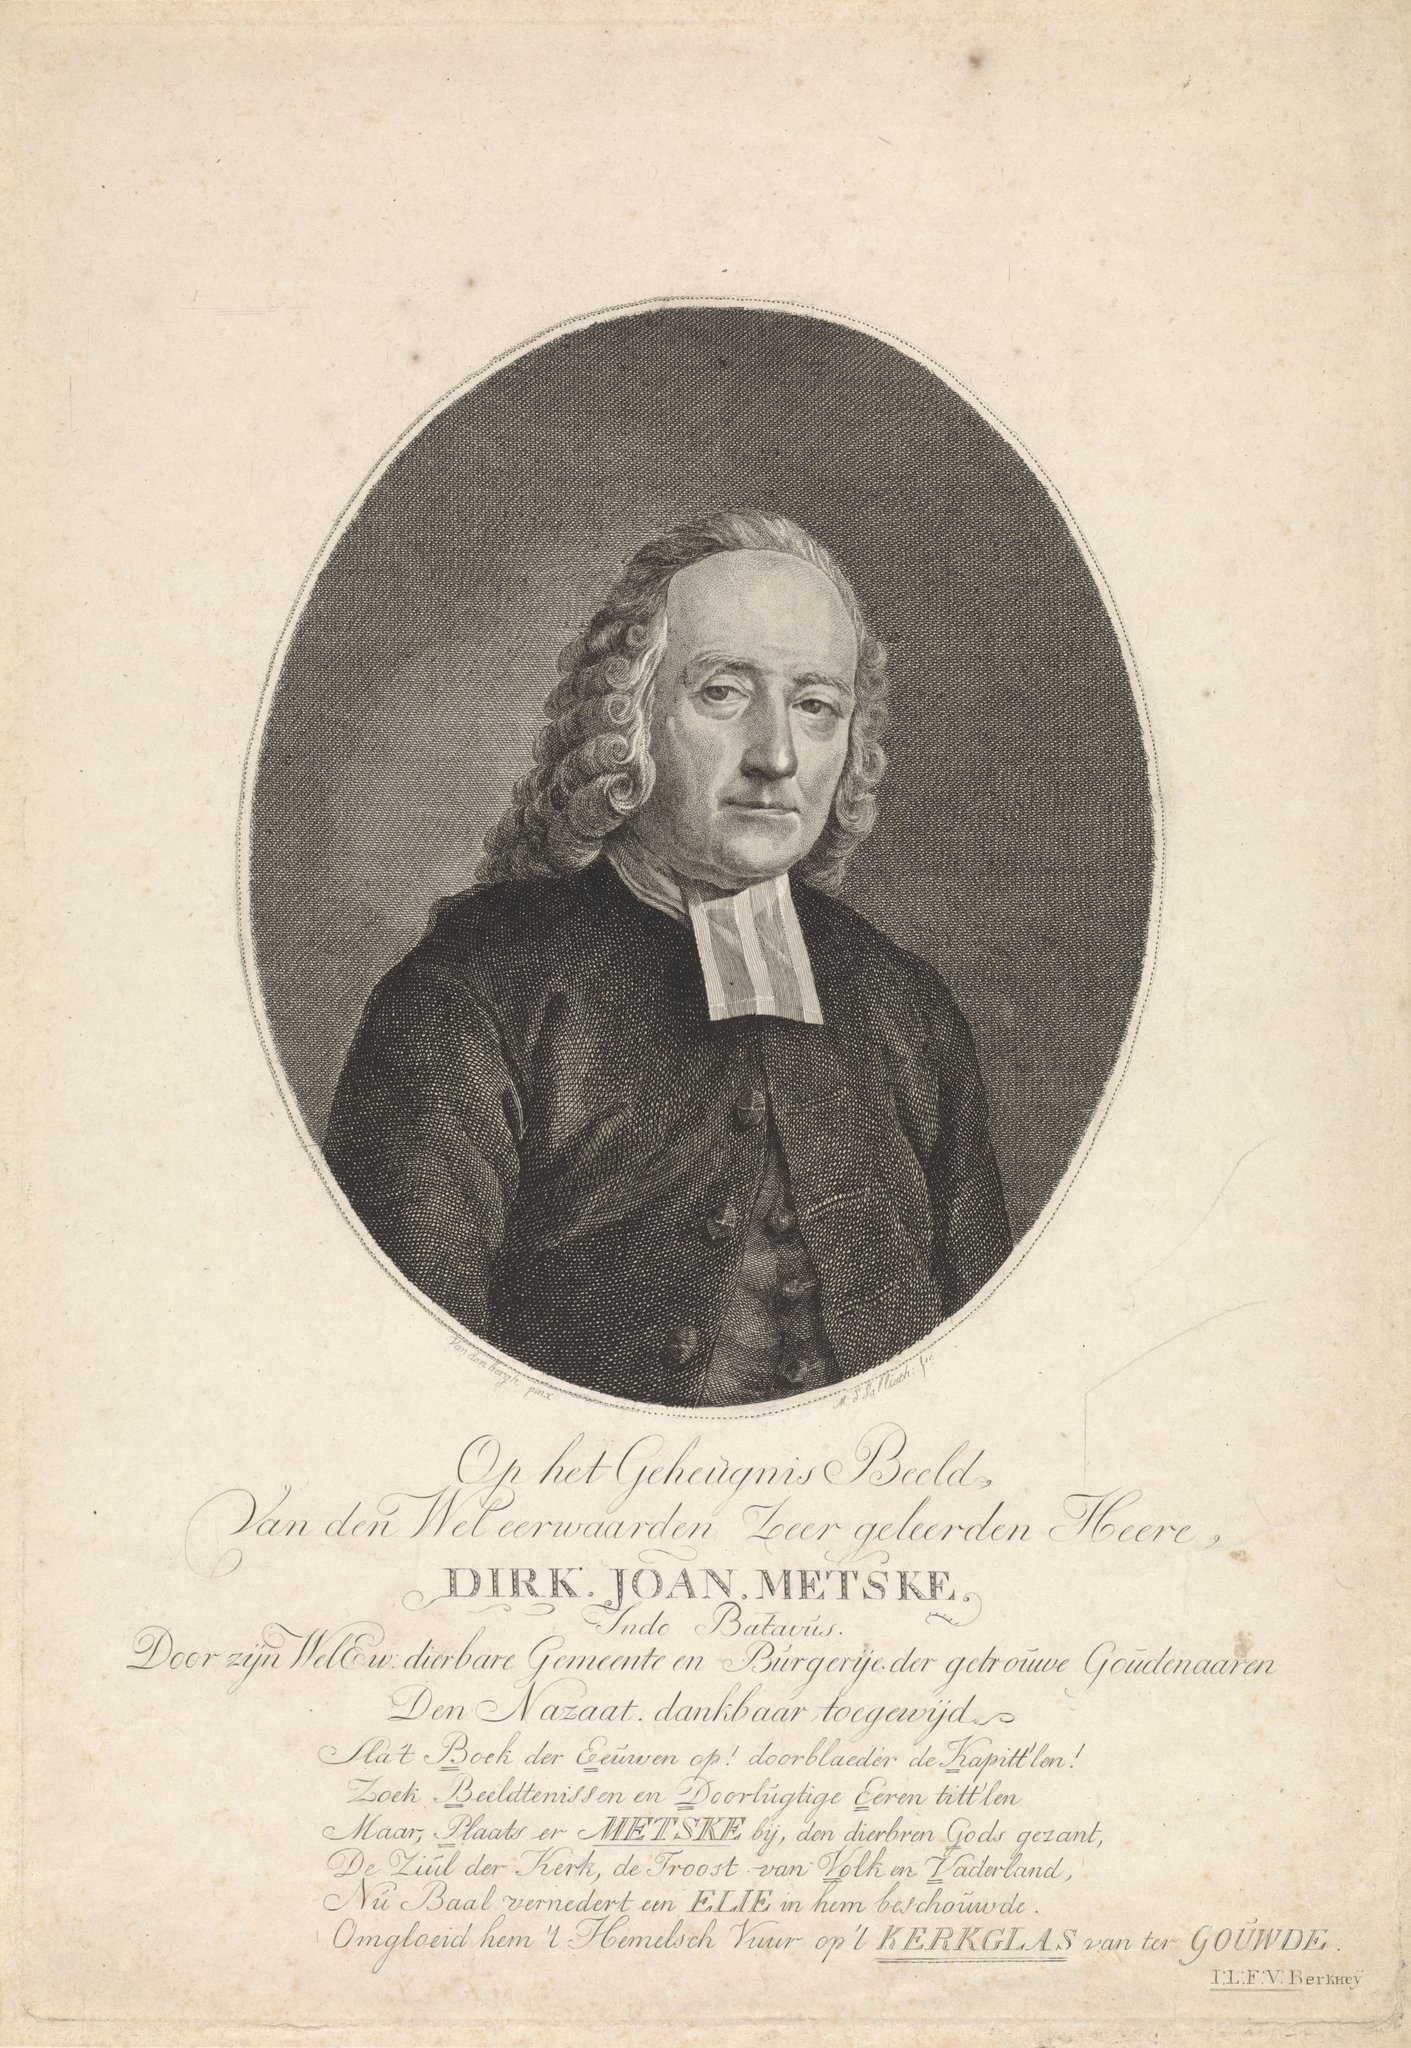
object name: print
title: Portret van Dirk Jan Metske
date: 1764-1791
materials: paper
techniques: etching, engraving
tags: predikant, dirk jan metske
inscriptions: collector's mark: Lugt 2228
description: Portret van Dirk Jan Metske, predikant te Gouda.